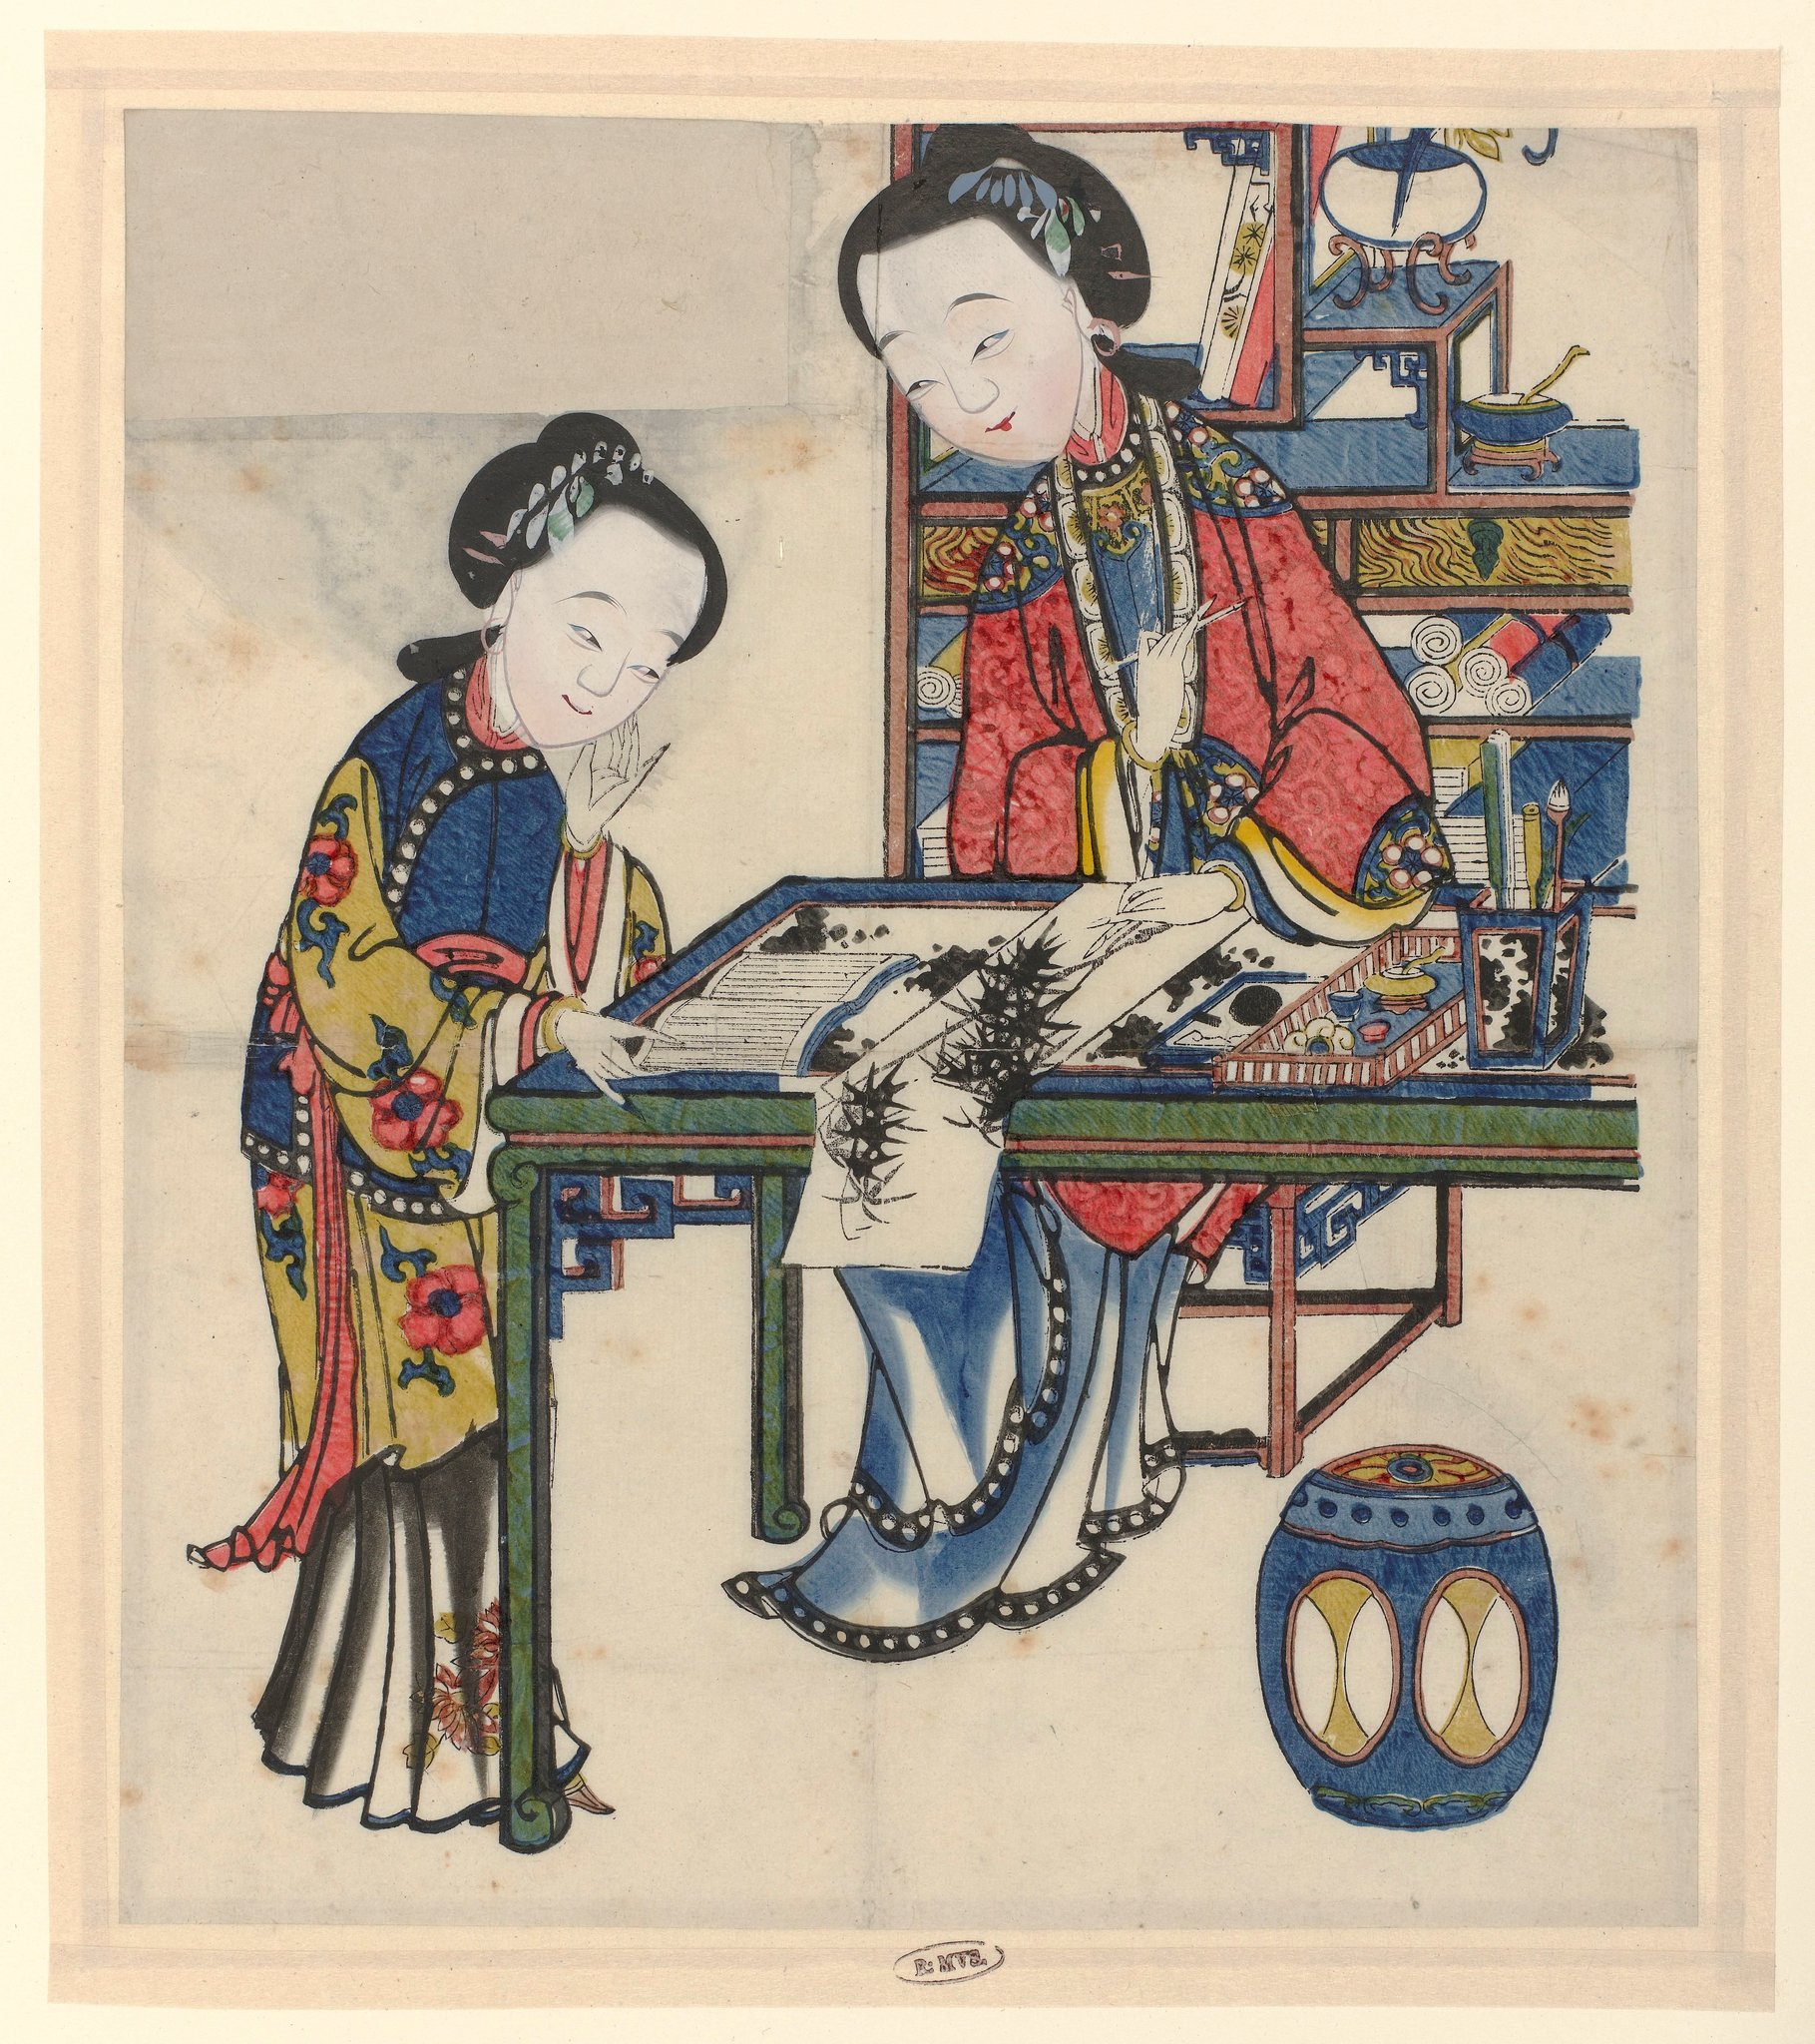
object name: print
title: Twee vrouwen bij een schrijftafel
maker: Anonymous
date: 1700-1799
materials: paper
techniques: woodcut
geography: china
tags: mother and baby or young child